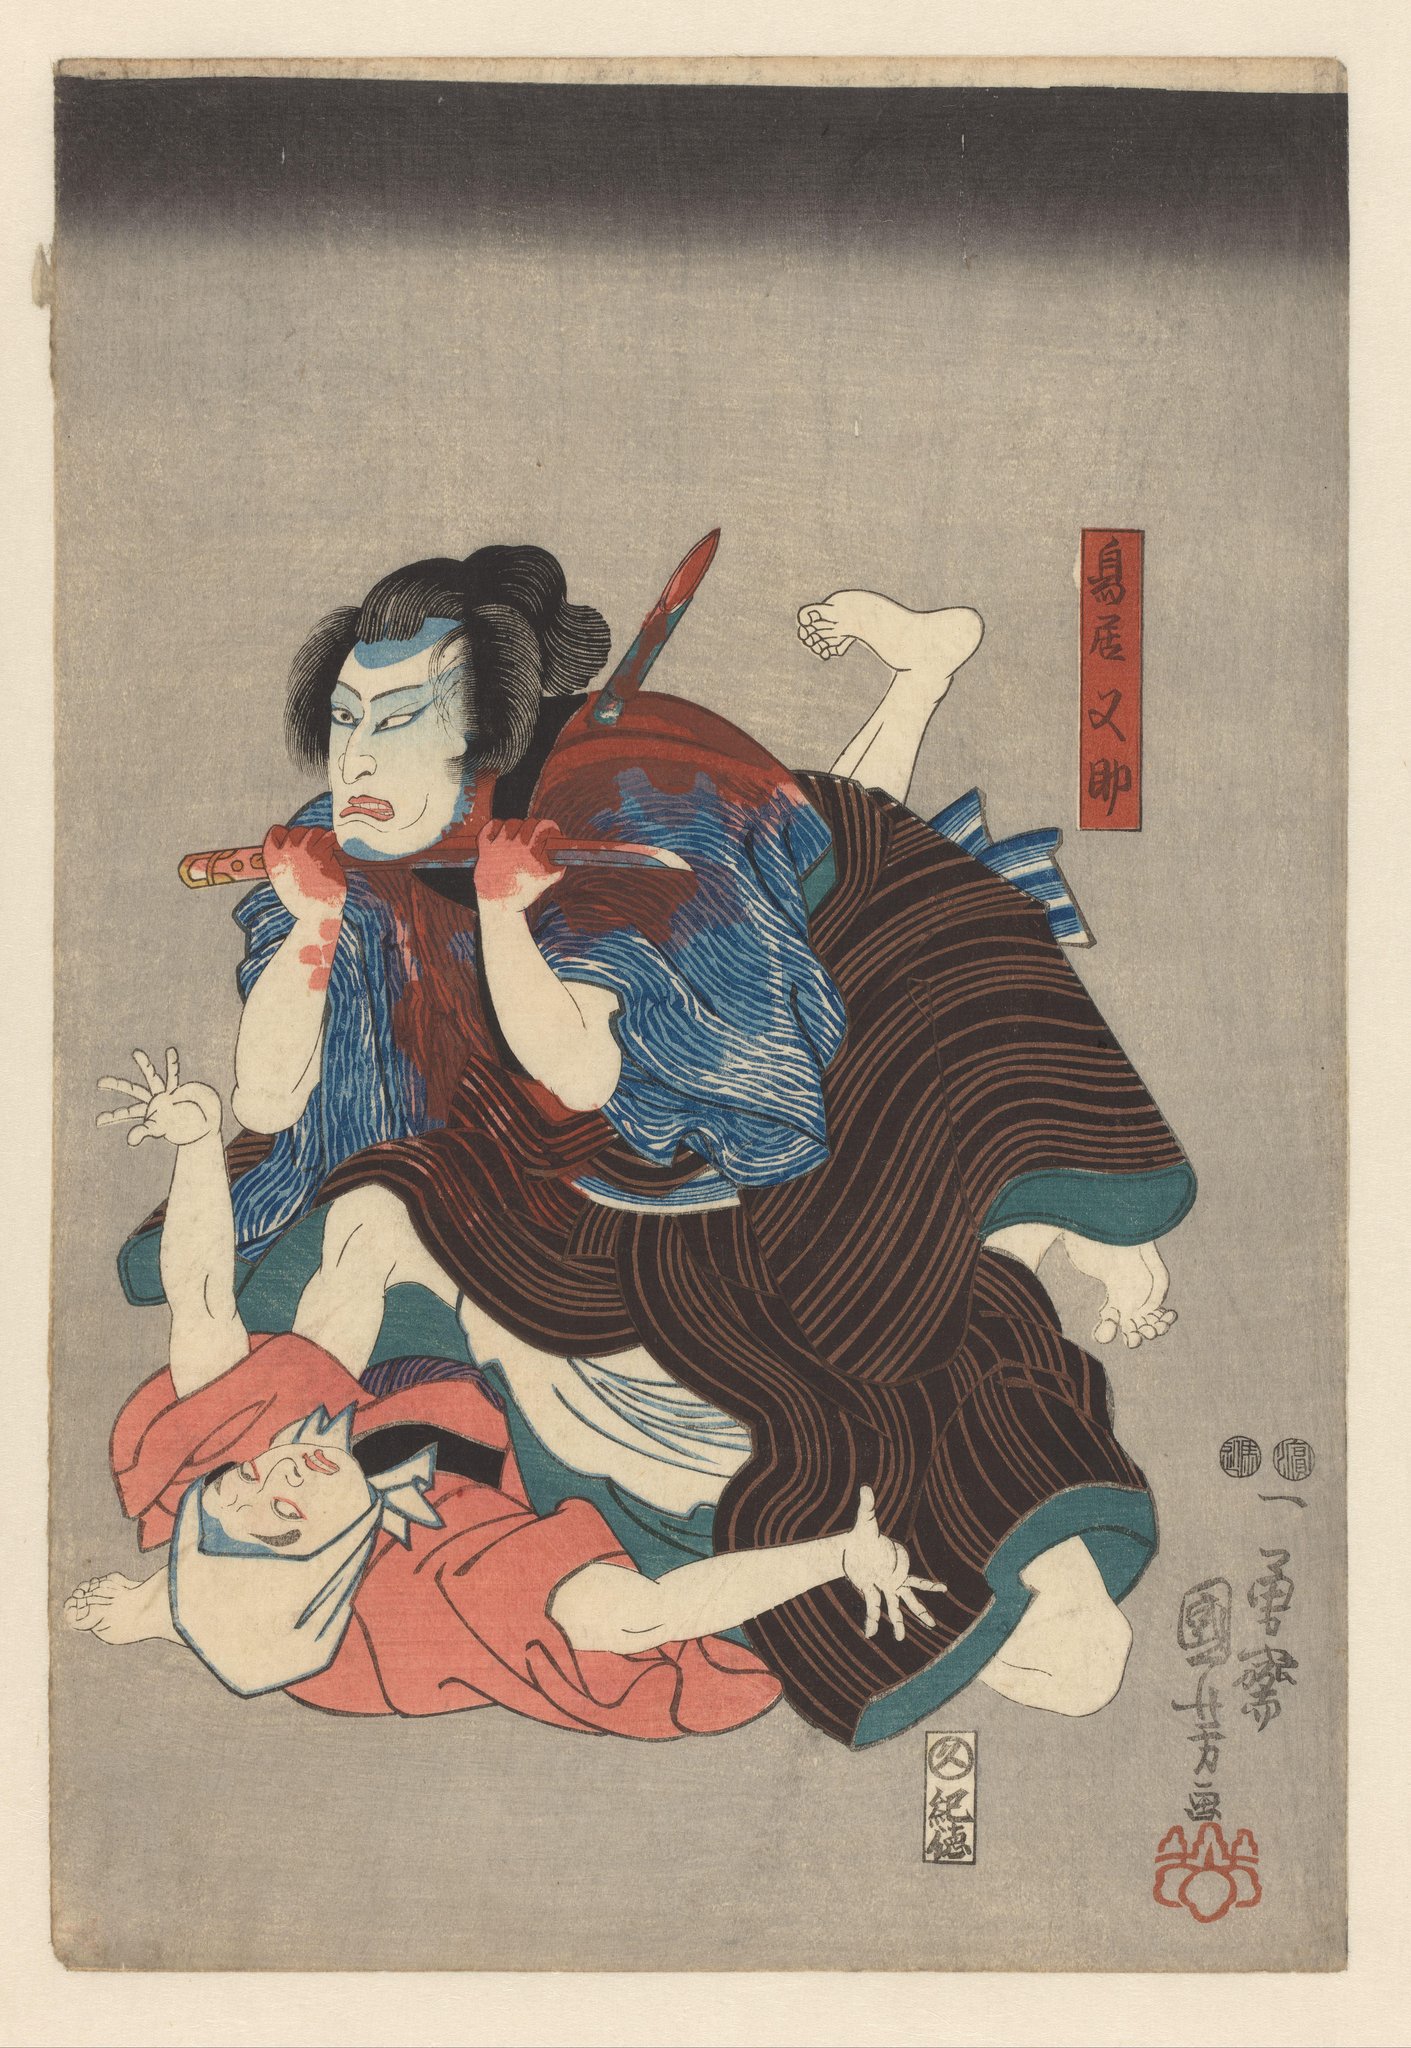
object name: print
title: Torii Matasuke cuts his throat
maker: utagawa kuniyoshi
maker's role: draughtsman, print maker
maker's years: 1798-1861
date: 1849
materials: paper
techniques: woodcut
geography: japan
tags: hacking and thrusting weapons: sword, seeking death, suicide, fighting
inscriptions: collector's mark: ‘rode origami kraanvogel’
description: Een man, gespiesd met bamboe stok, snijdt zijn eigen keel door terwijl hij een man met oranje jas op de grond houdt.